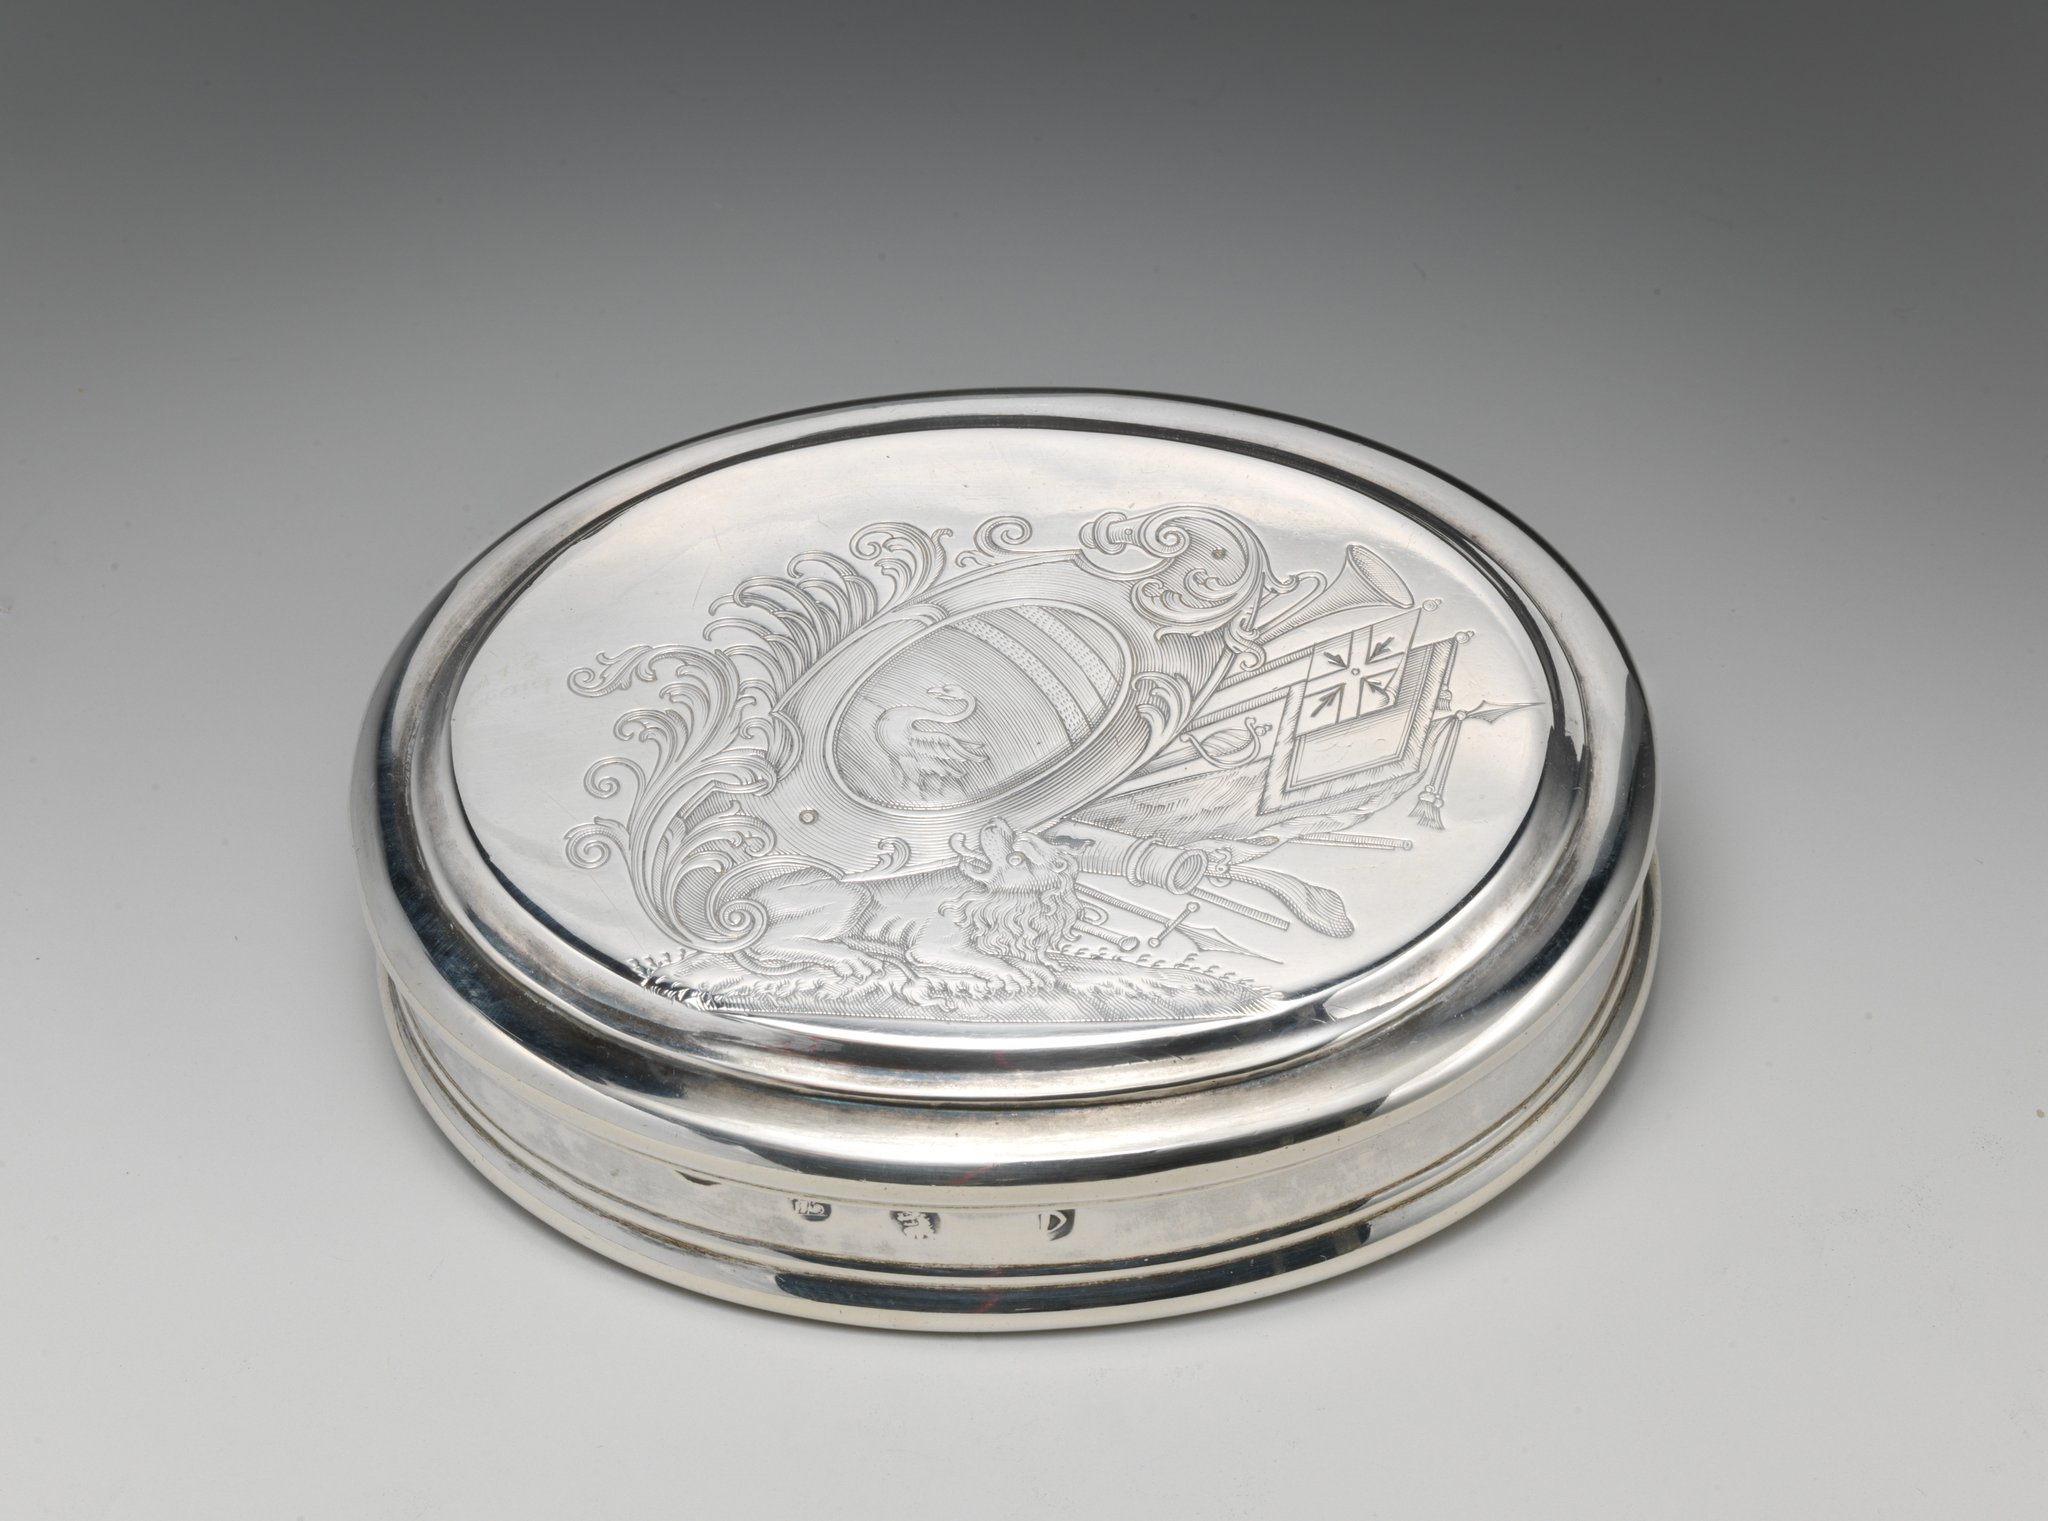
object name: tobacco box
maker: edward cornock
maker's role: maker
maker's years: 1701-1731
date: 1709-1710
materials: silver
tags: birds,lions,flags